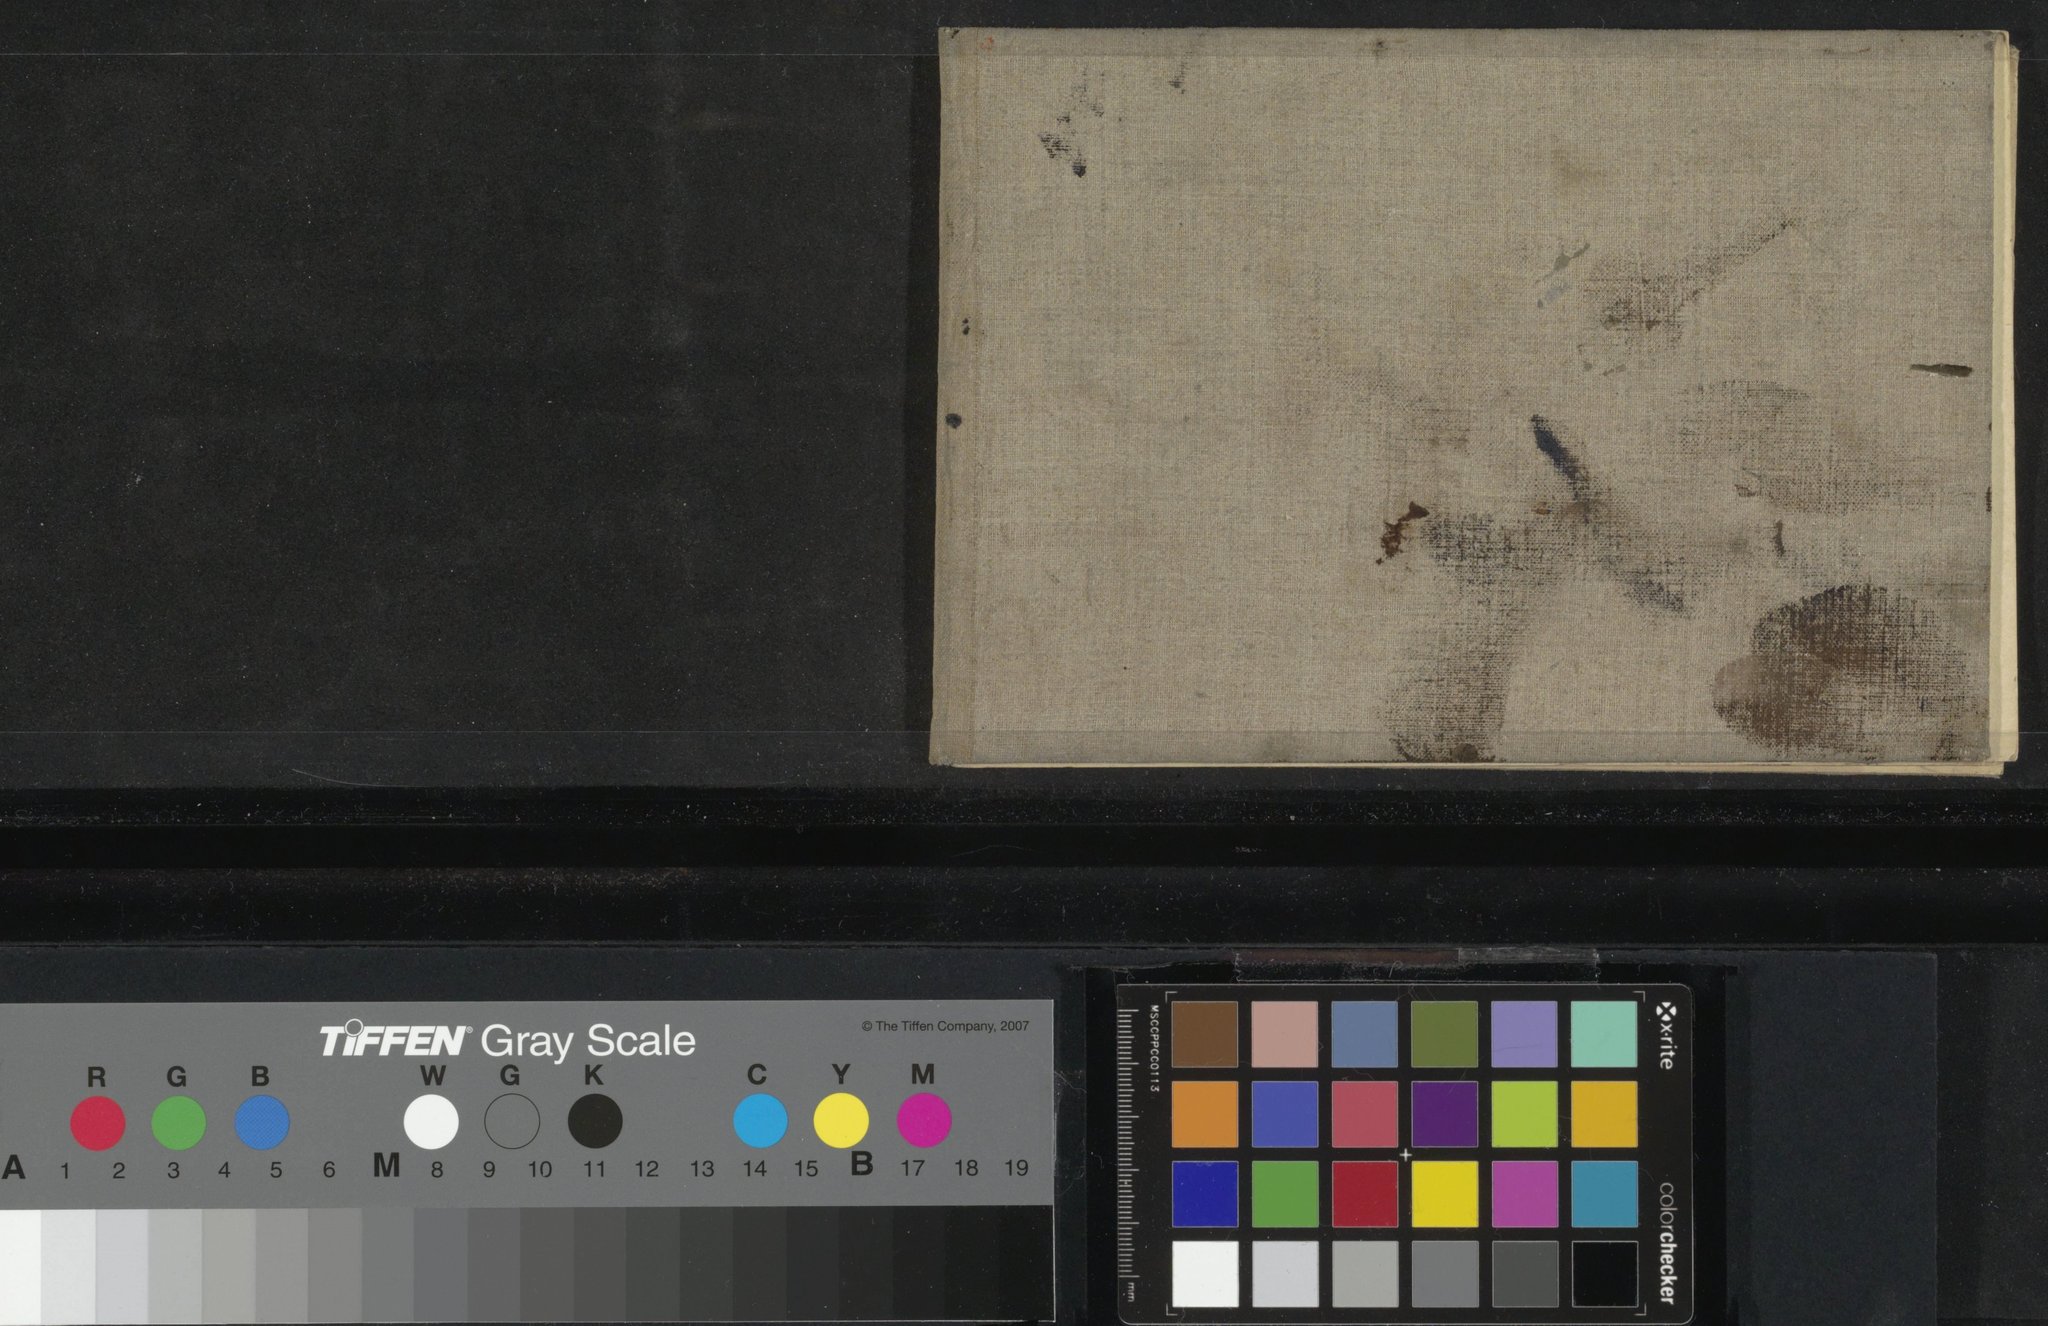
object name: sketchbook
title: Schetsboek met 4 bladen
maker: willem witsen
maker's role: draughtsman, painter, print maker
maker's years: 1860-1923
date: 1875-1923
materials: cardboard, chalk, linen, paper, pencil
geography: netherlands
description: Dit boek bevat ook enkele blanco pagina's.